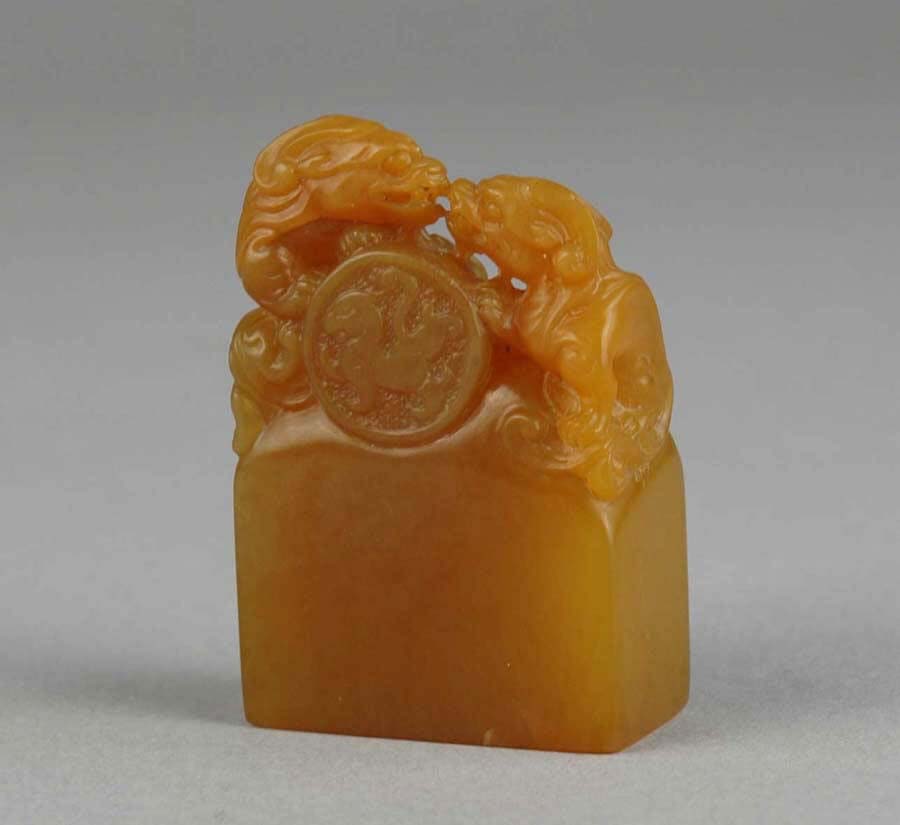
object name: seal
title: Square Seal with Knob In the Shape of Three Felines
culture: chinese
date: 1701-1800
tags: animals